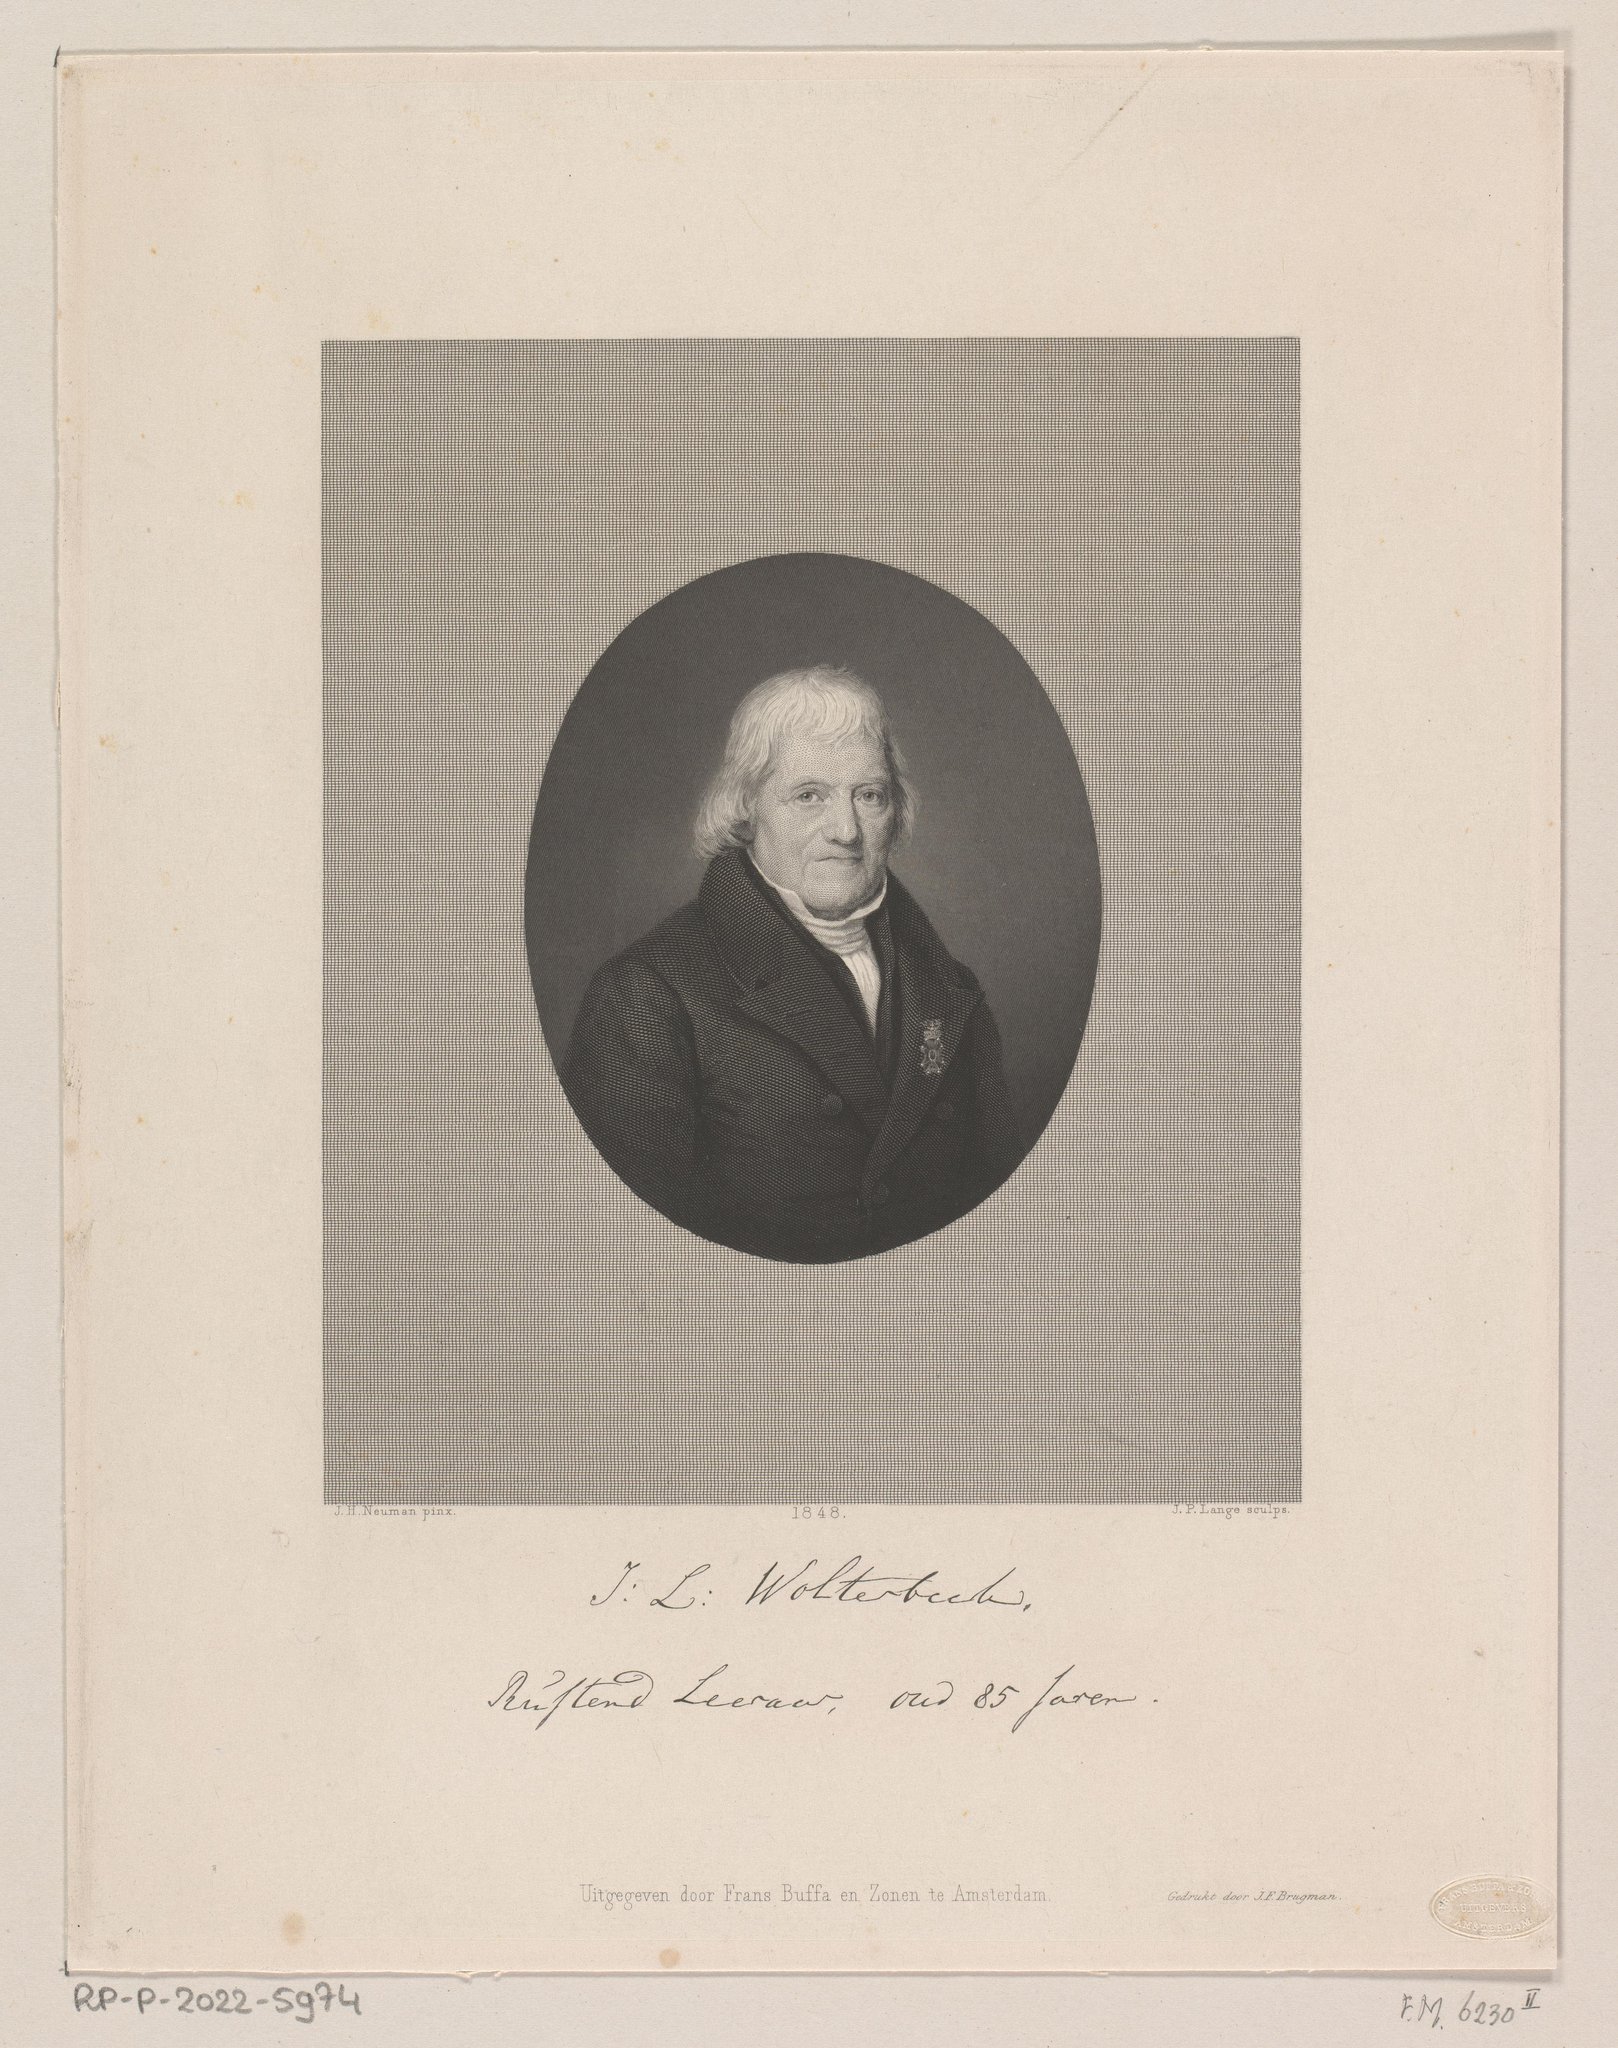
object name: print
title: Portret van Johannes Leonardus Wolterbeek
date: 1848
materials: paper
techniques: engraving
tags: knighthood order, historical persons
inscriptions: check stamp: ‘Frans Buffa & Zonen Uitgevers Amsterdam’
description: Met eenregelig onderschrift in het Nederlands.